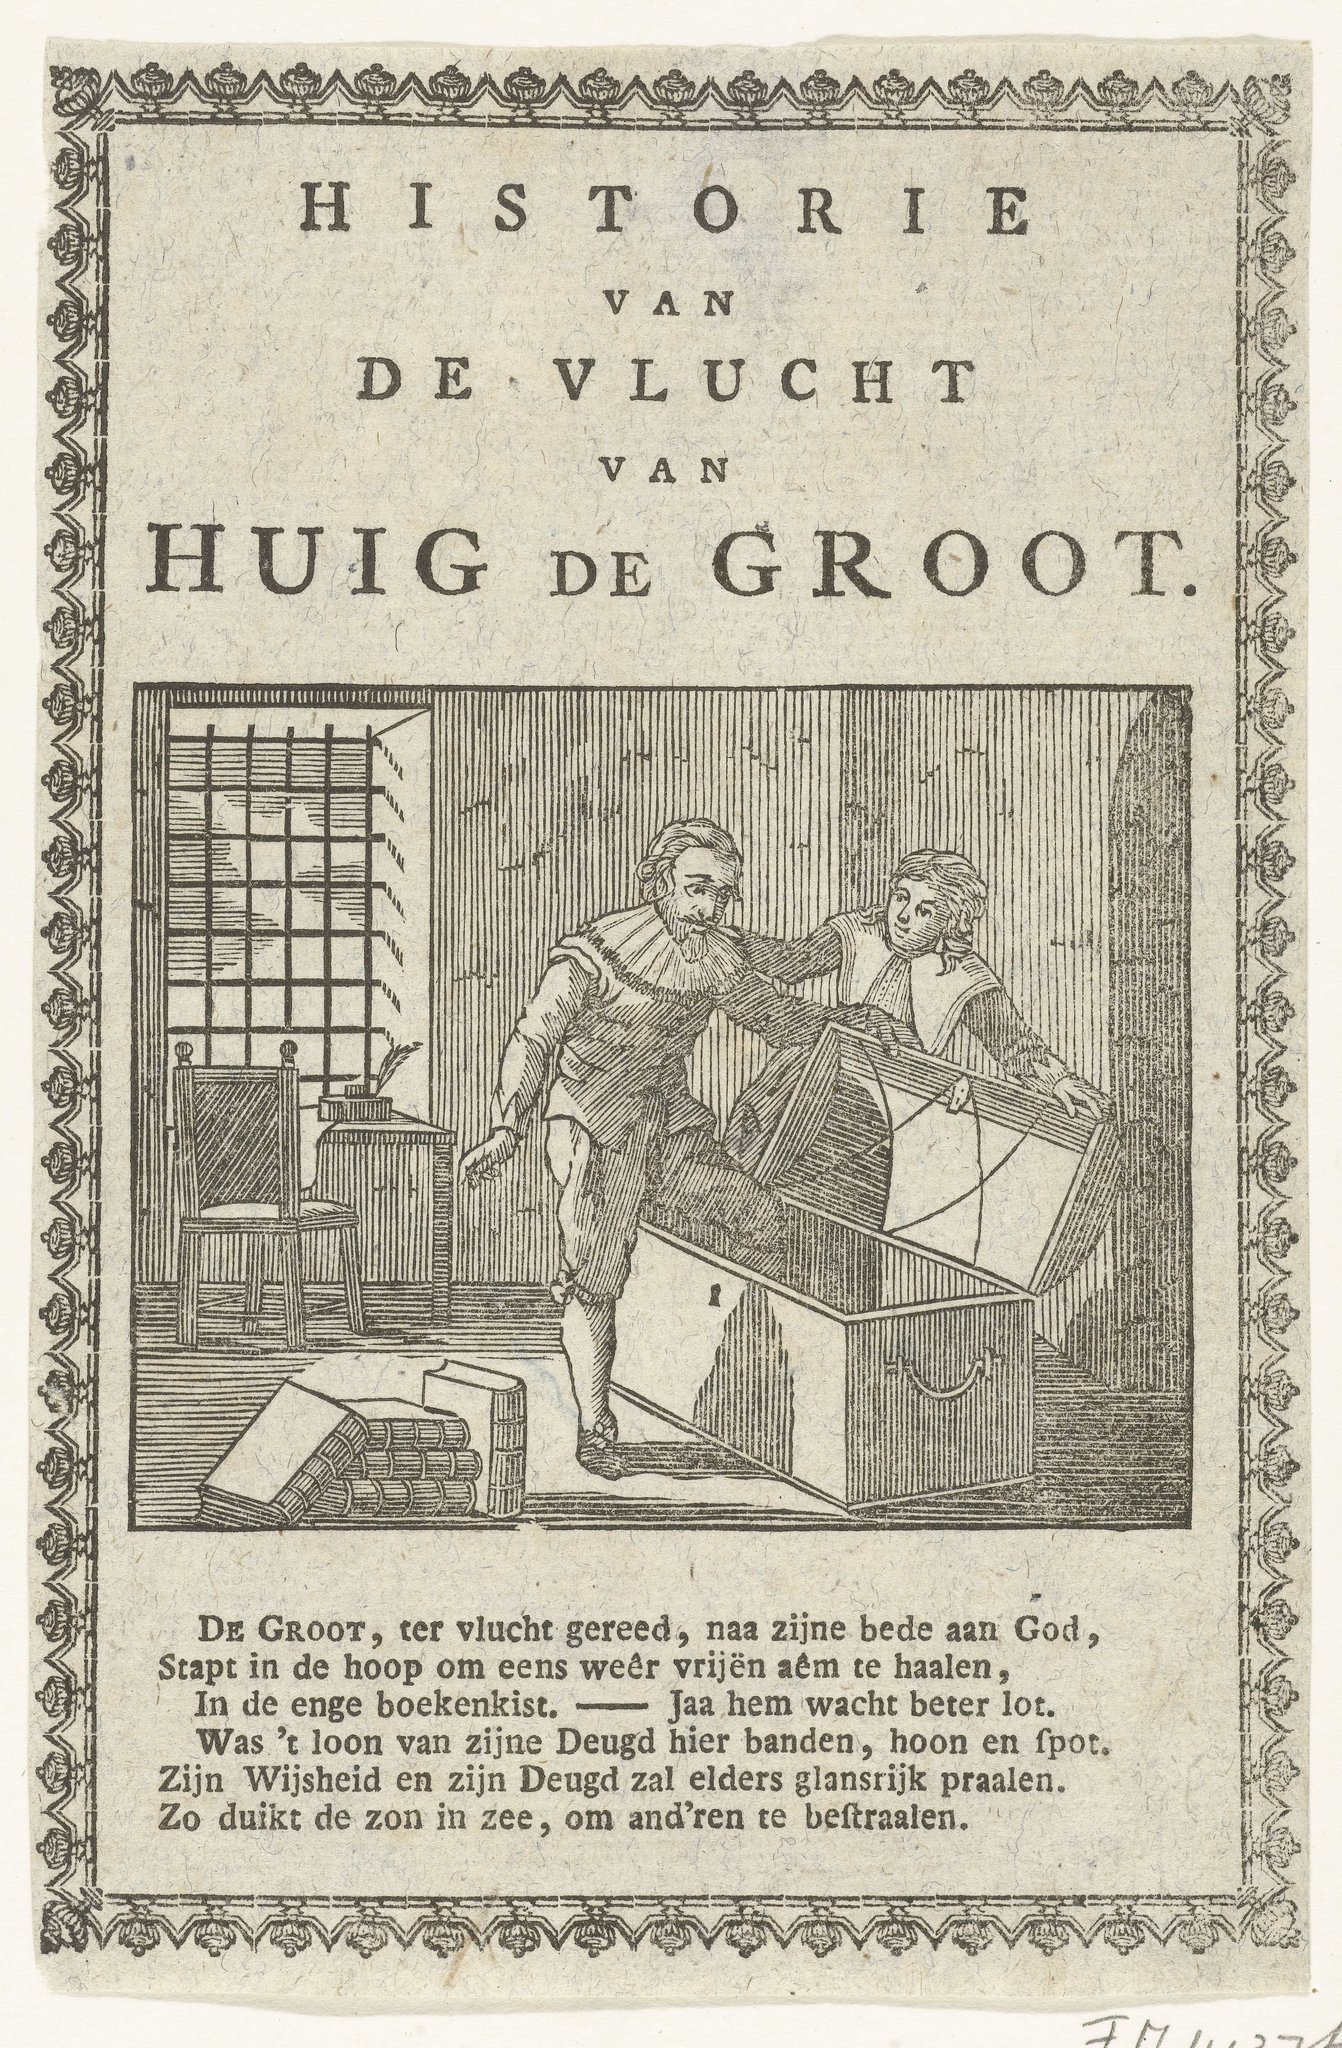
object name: print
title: Titelprent voor het schoolboekje Historie van de vlucht van Huig de Groot, 1800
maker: Anonymous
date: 1795-1800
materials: paper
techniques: letterpress printing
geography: netherlands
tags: delft, hugo de groot, law and jurisprudence (+ escape from prison), loevestein castle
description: Titelprent voor het schoolboekje Historie van de vlucht van Huig de Groot, 1800. Hugo de Groot in de boekenkist stappend, hierbij geholpen door zijn vrouw Maria van Reigersberch, die het plan voor de ontsnapping met de boekenkist had bedacht, 22 maart 1621. Onder de voorstelling een vers van 6 regels.